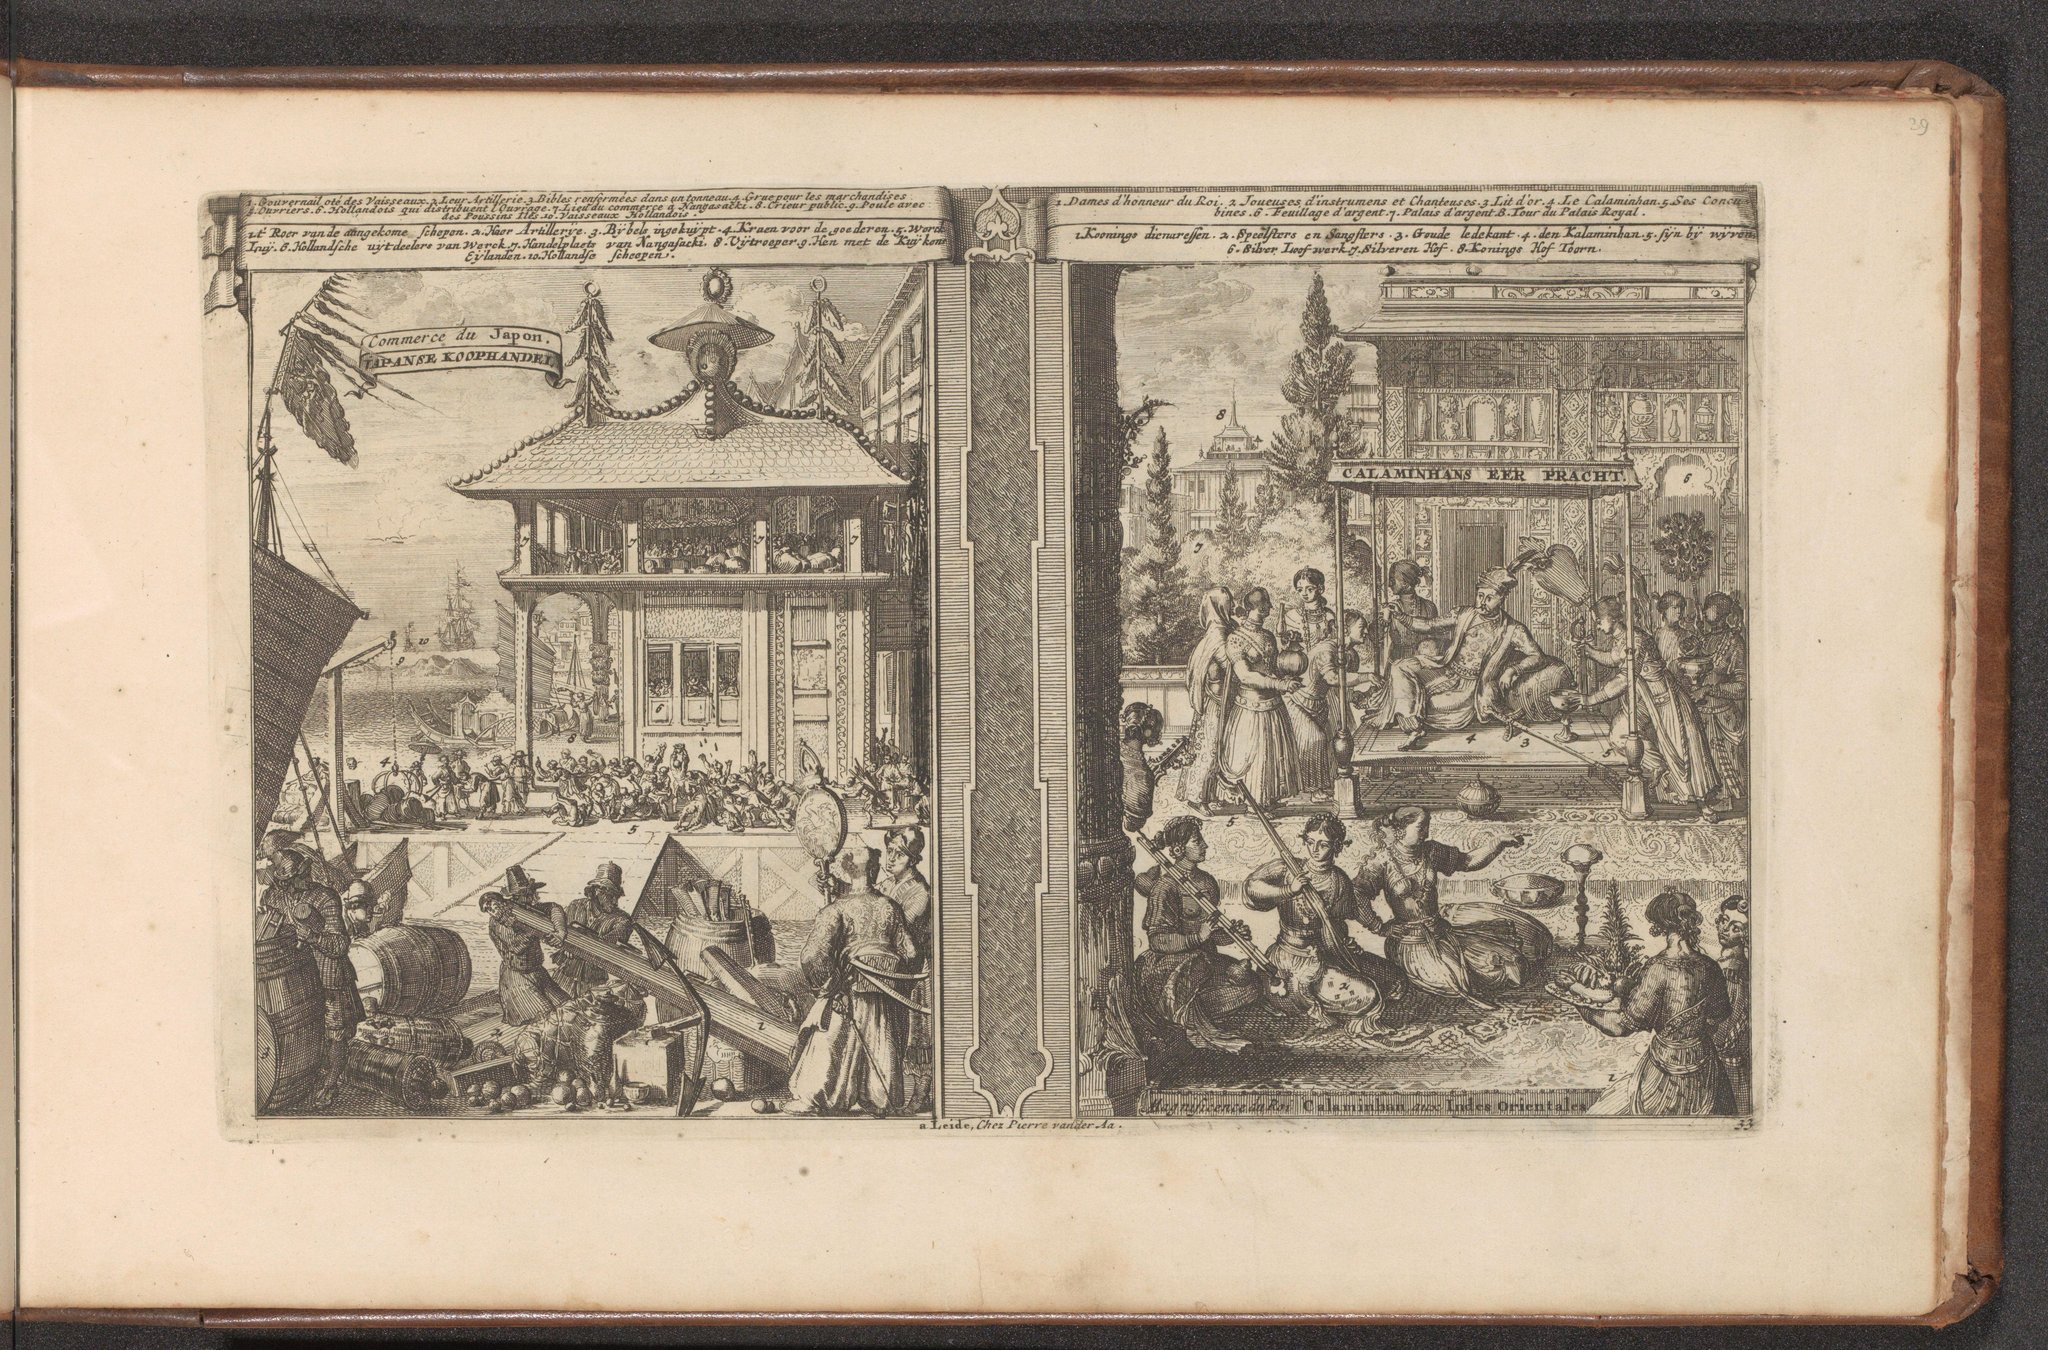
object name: album leaf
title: Les Indes Orientales et Occidentales et autres lieux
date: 1682-1733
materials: paper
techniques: etching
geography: leiden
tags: musical instruments; group of musical instruments, locations for trading, vocal music, singing, royal household; courtiers, retinue, train, book-shop, bookseller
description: Voorstelling in twee delen. Links de koophandel en een handelshuis in Japan. Op de voorgrond een scheeplading, waaronder enkele tonnen met bijbels. In de verte enkele Hollandse schepen op zee. Op de rechter voorstelling het hof van de koning van de Calaminhans in Oost-Indië. De koning zit op een kussen onder een baldakijn en wordt geflankeerd door zijn dienaressen en zijn vrouwen. Drie vrouwen maken muziek. Met een legenda in het Nederlands en het Frans. De prent maakt deel uit van een album.